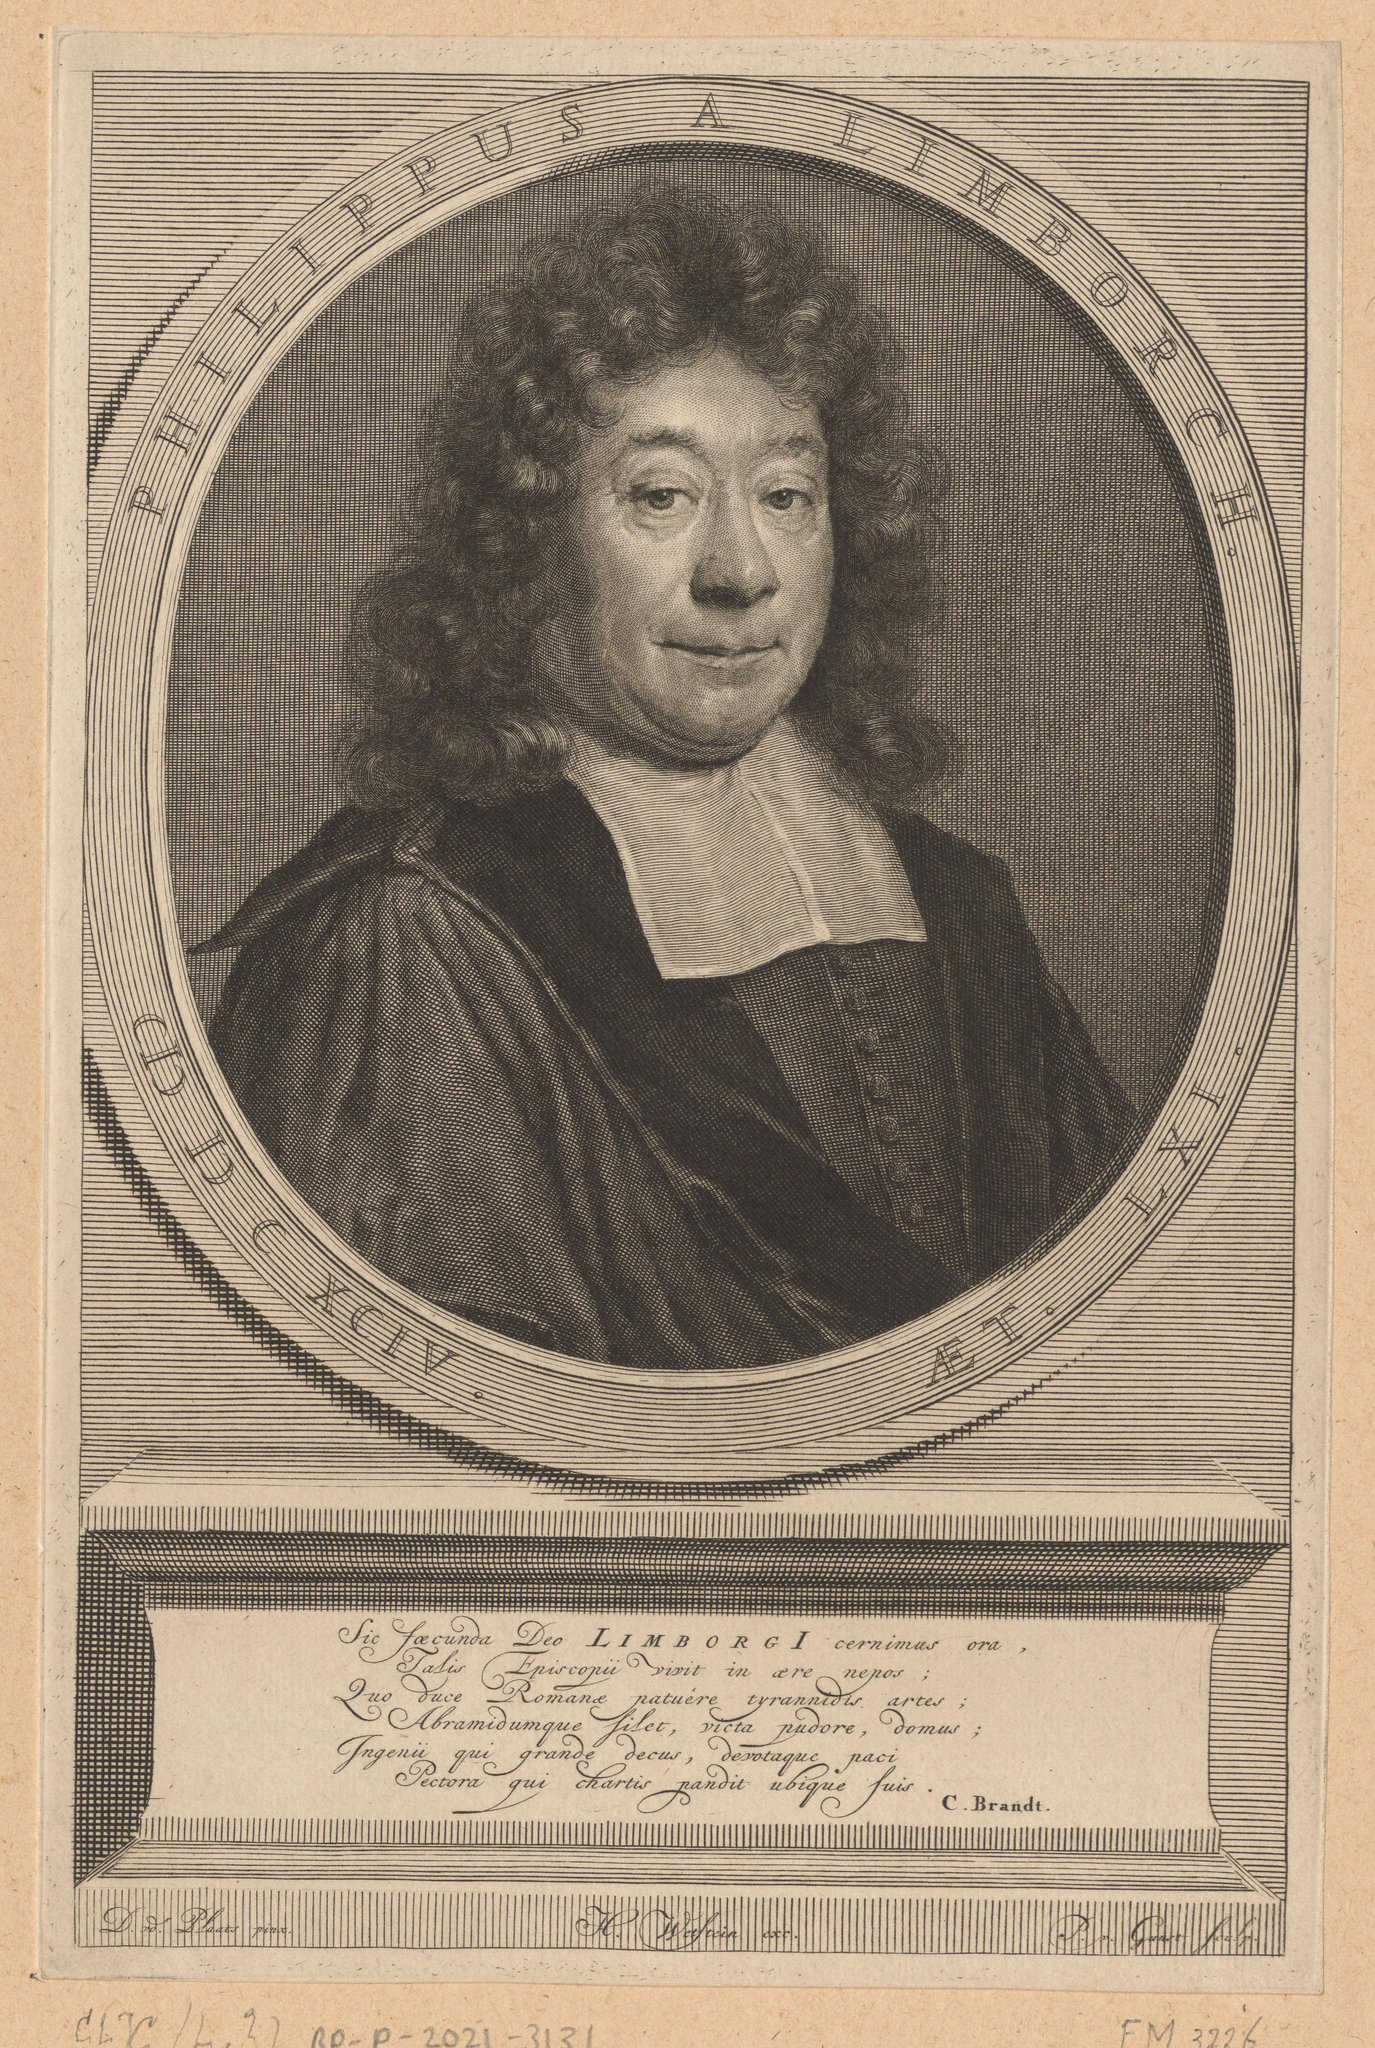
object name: print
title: Portret van Philippus van Limborch op 61-jarige leeftijd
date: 1700-1711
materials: paper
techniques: engraving, etching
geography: amsterdam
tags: amsterdam, theologian, ornament ~ medallion, historical persons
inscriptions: collector's mark: ‘C.L.J.C.’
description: Prent in eerdere staat gebruikt in: Limborch, Philippus van. Theologia christiana ad praxin pietatis ac promotionem pacis Christianae unice directa. Amsterdam: Sebastiaan Petzold, 1700.